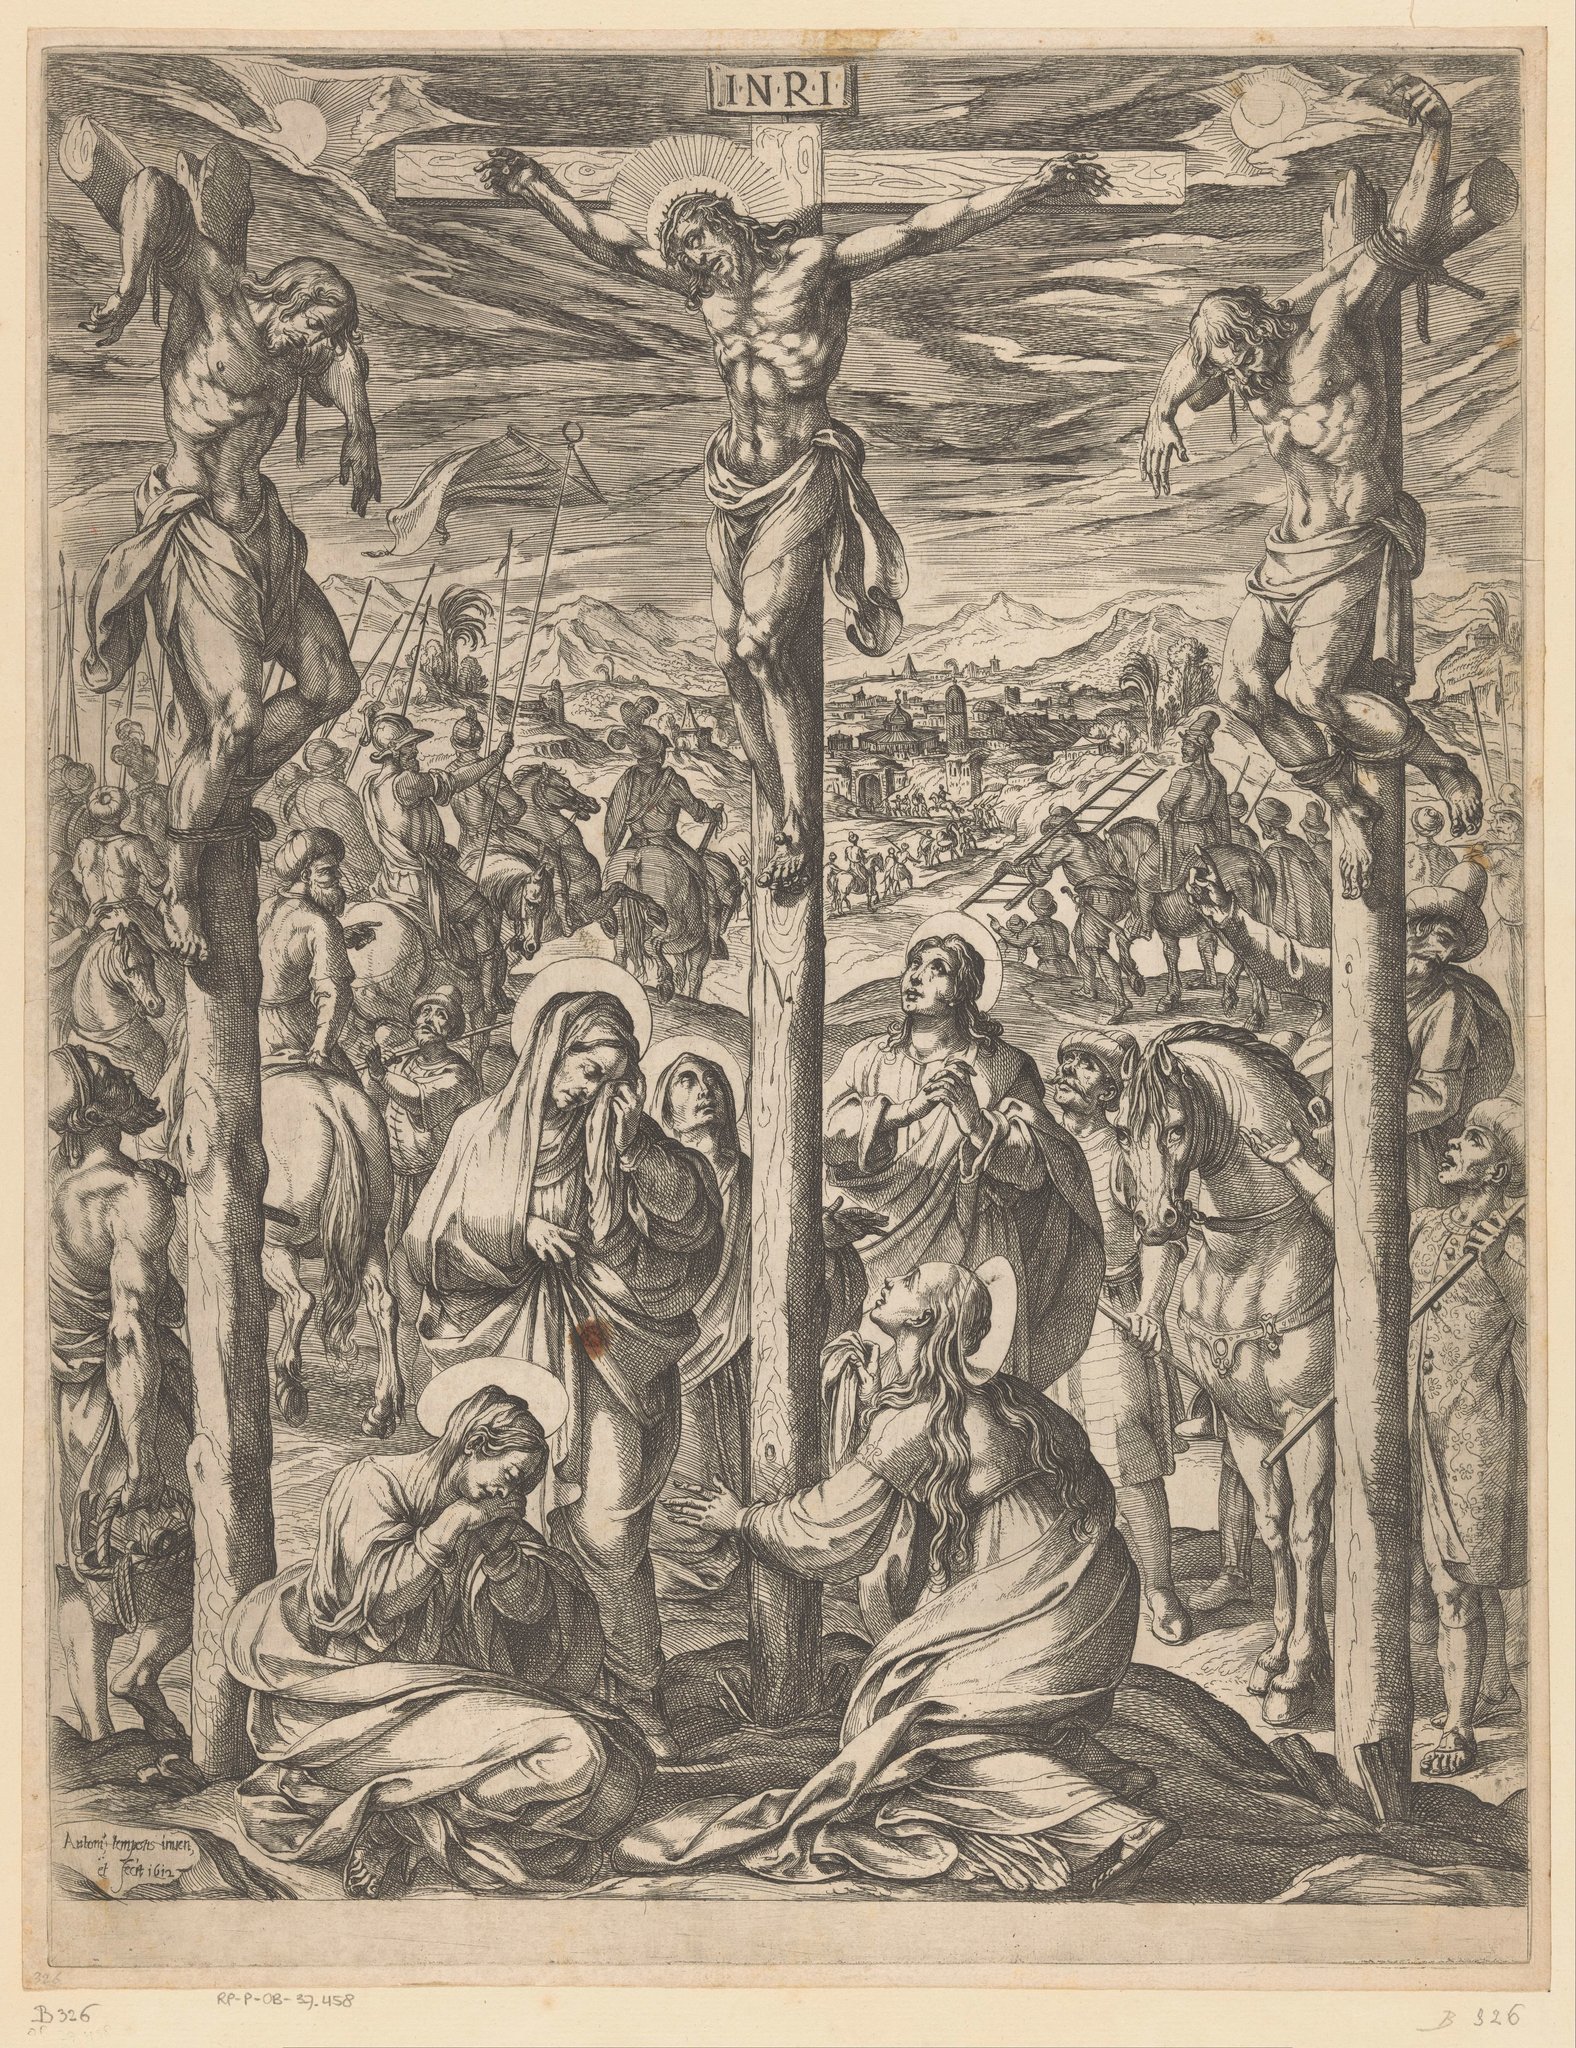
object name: print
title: Kruisiging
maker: antonio tempesta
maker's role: draughtsman, painter, print maker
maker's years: 1555-1630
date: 1612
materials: paper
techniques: etching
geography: italy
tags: crucified christ, with particular persons under the cross - dd - the three crosses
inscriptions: collector's mark: Lugt 240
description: Christus hangt aan het kruis, tussen de twee kruisen met de twee dieven. Onder het kruis treuren de Maria's, Johannes en Maria Magdalena. Op de achtergrond vertrekt de menigte toeschouwers en soldaten weer terug naar de stad.